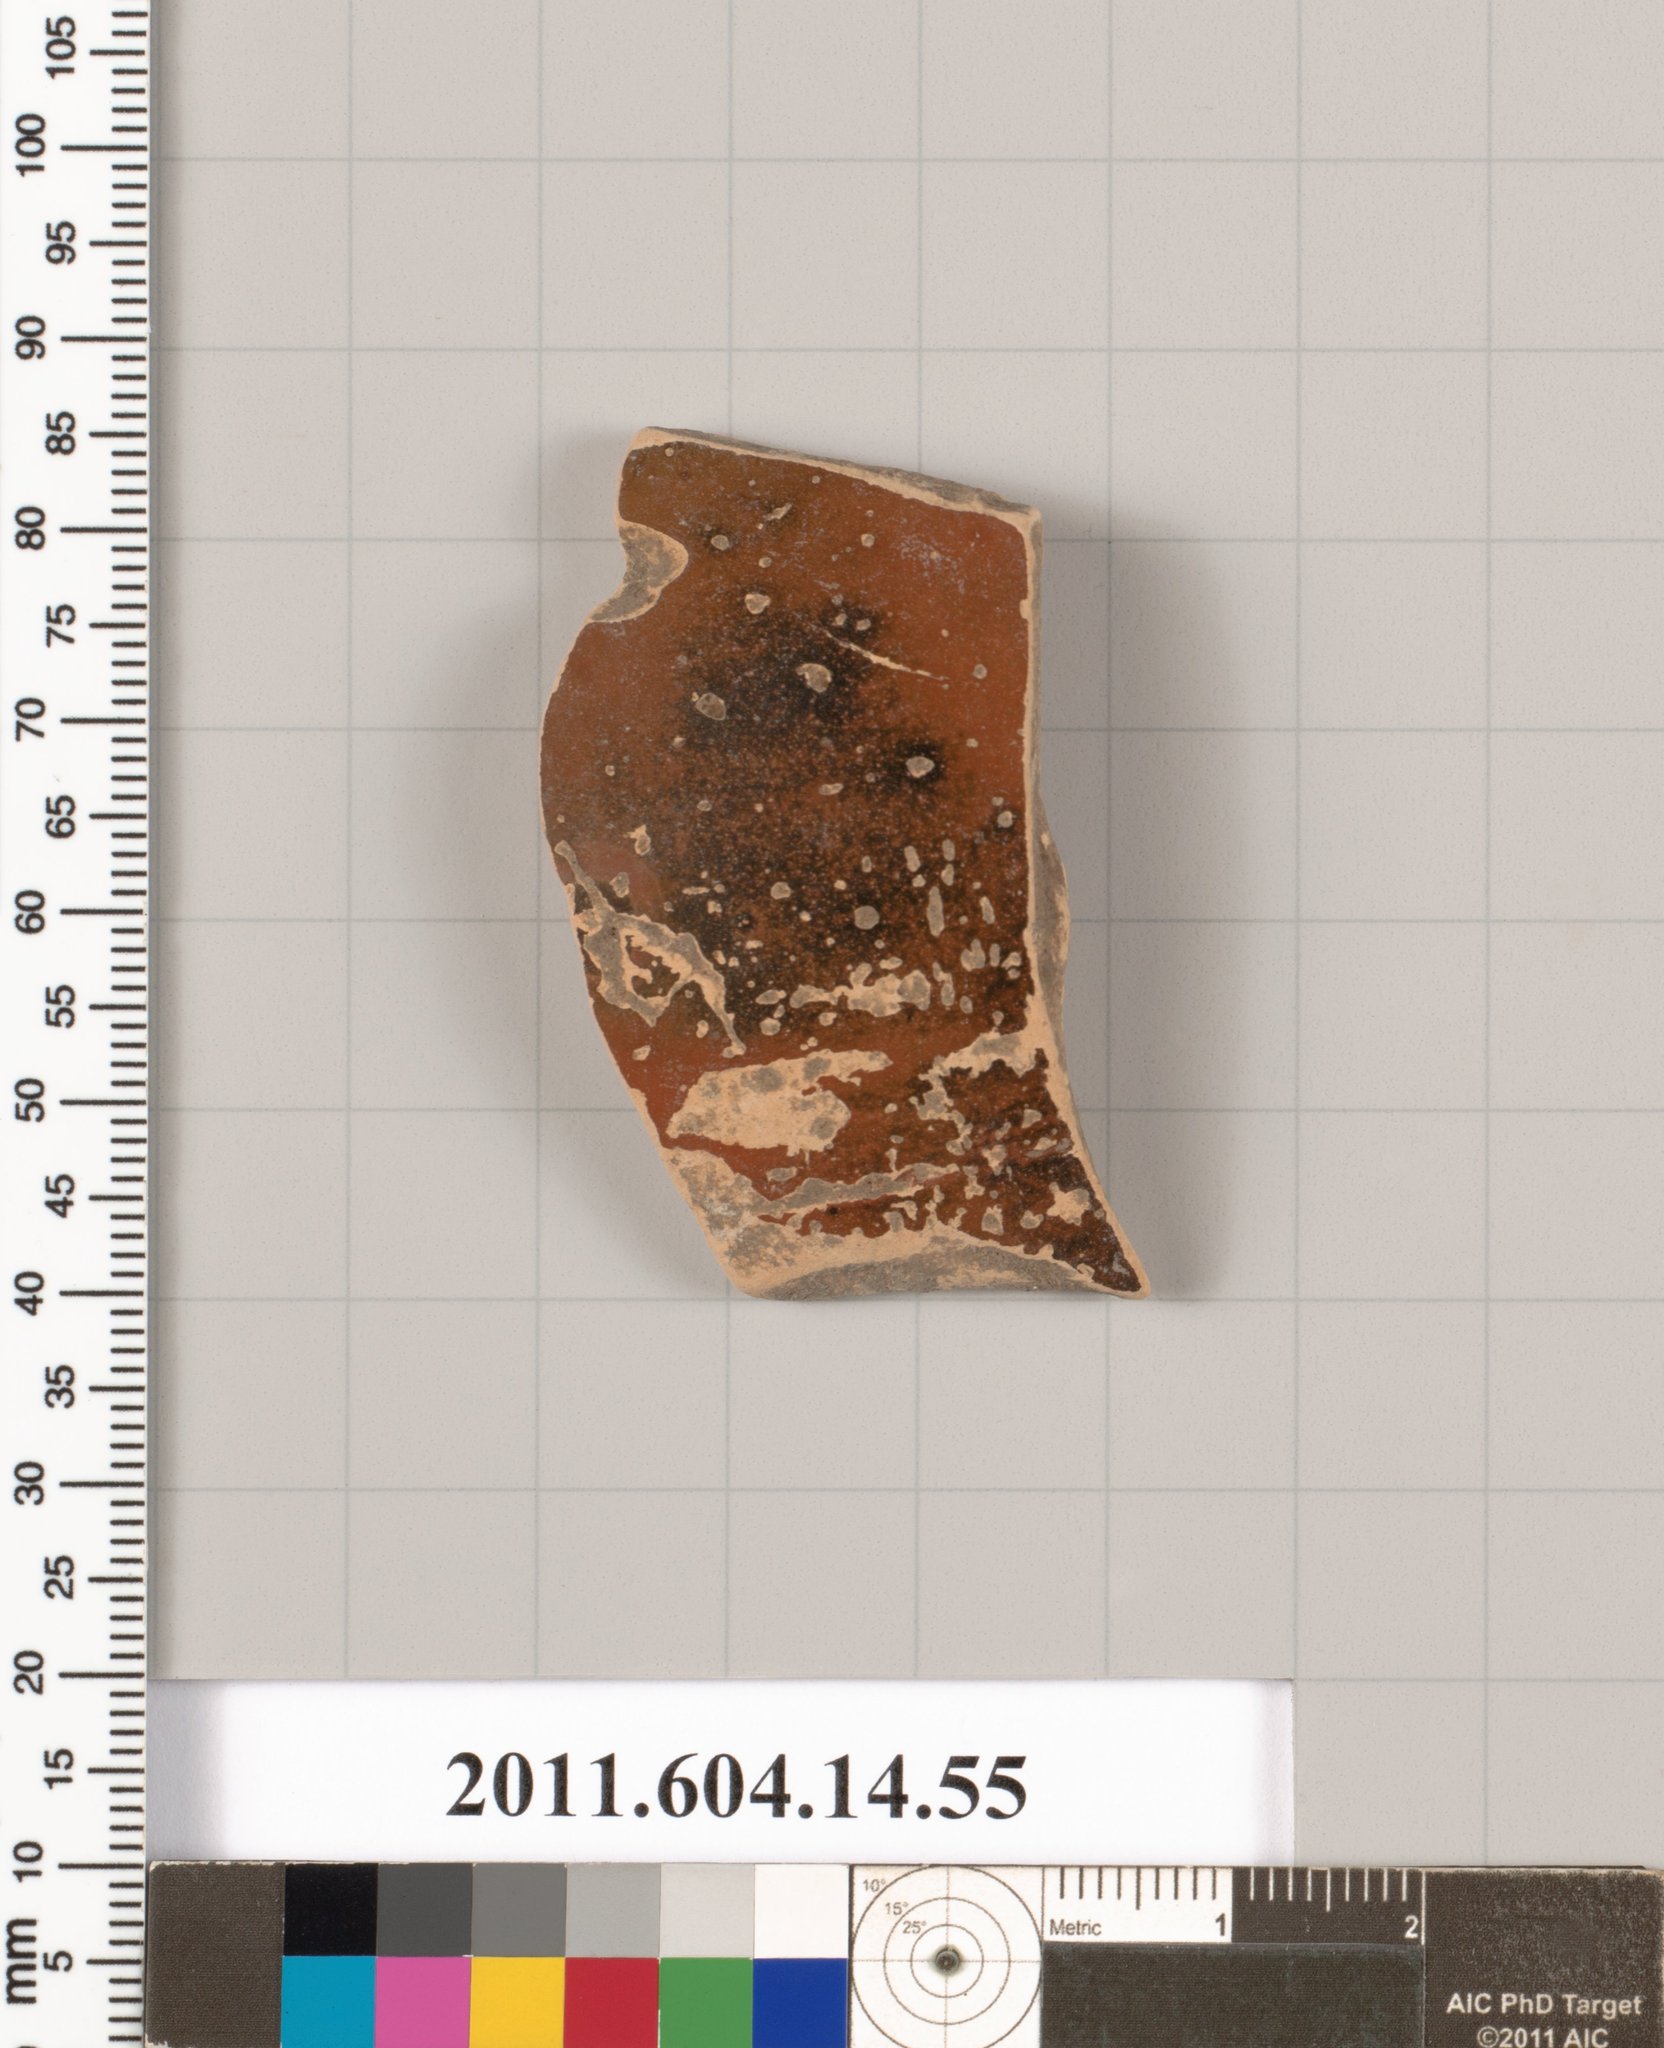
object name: fragment of a bowl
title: Terracotta fragment of a bowl?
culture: unknown fabric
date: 600-301 BCE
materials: terracotta